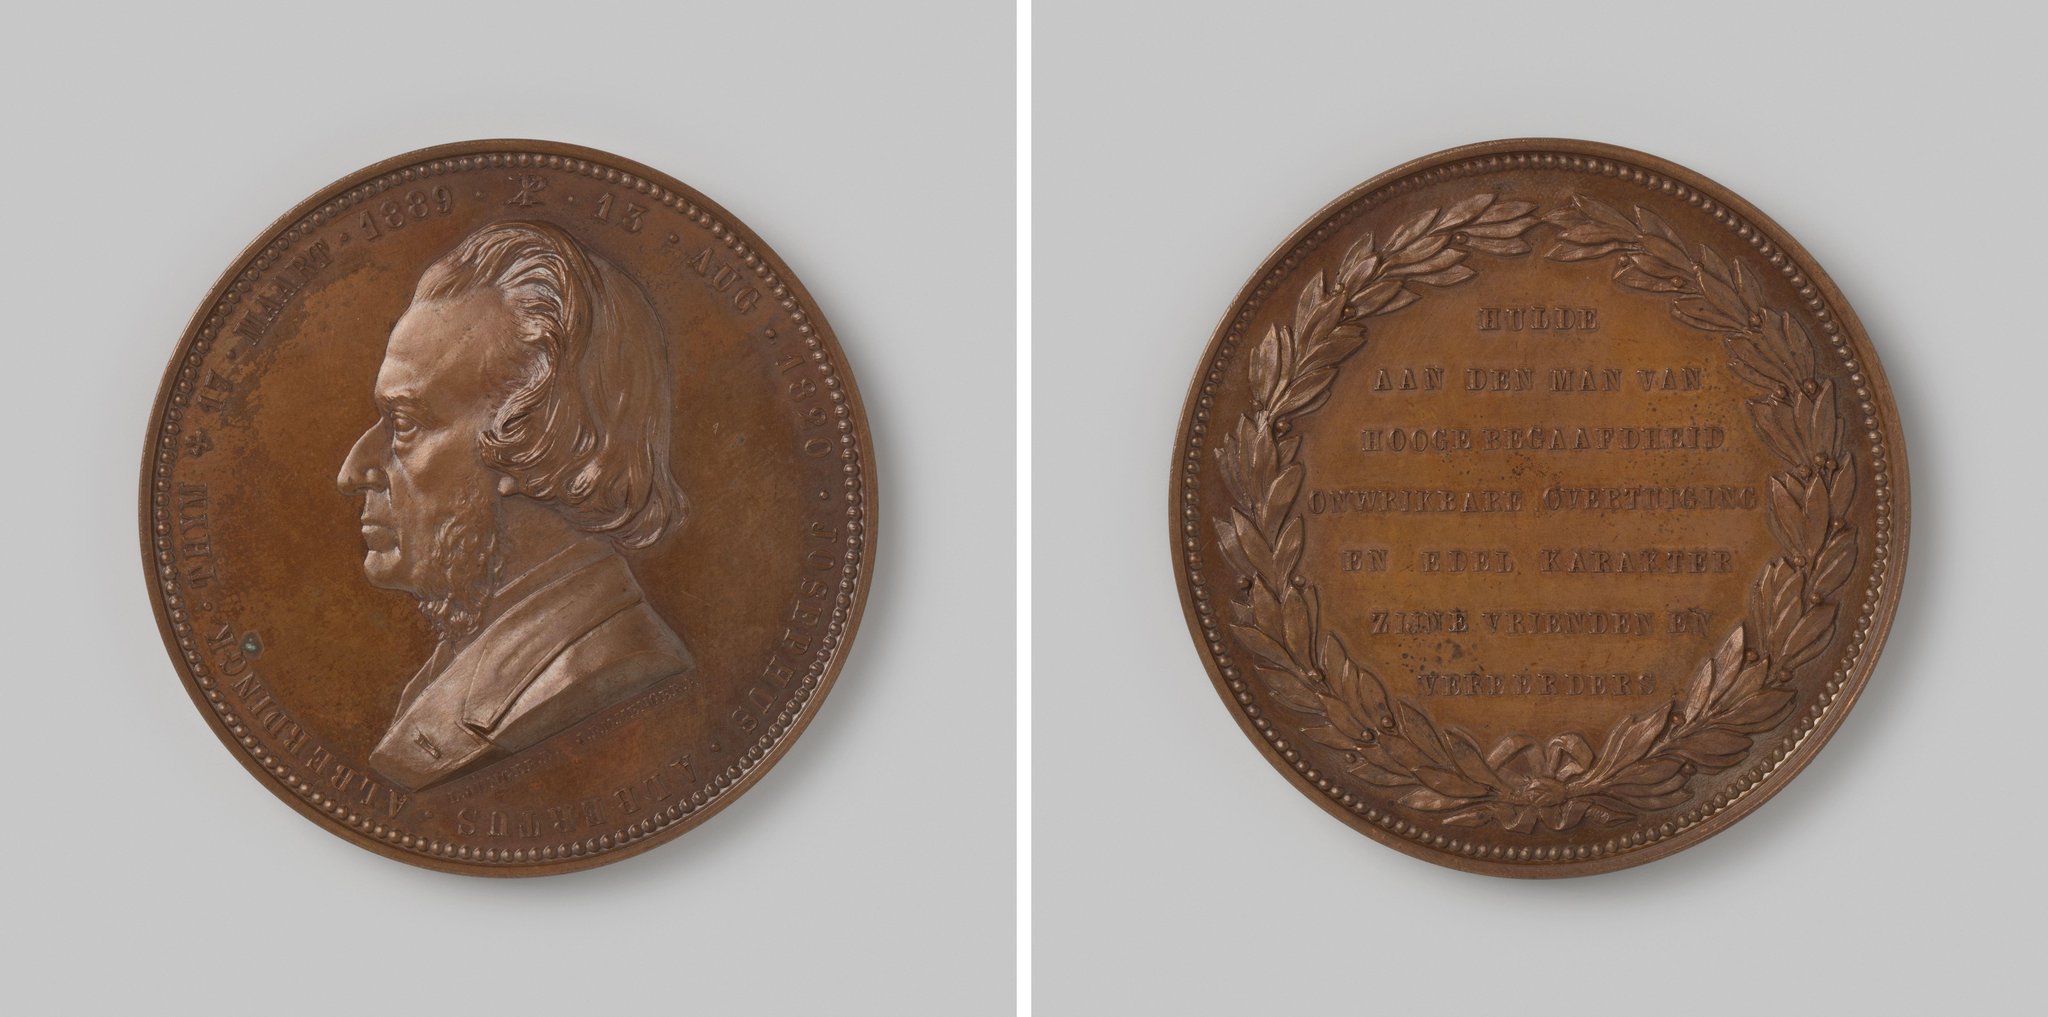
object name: history medal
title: Overlijden van Josephus Albertus Alberdingk Thym 1889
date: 1889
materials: bronze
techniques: striking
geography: amsterdam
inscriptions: factory mark: ‘mercuriusstaf’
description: Bronzen penning, op de voorzijde het borstbeeld van Alberdingk Thym naar links met omschrift, op de keerzijde zeven regels tekst tussen samengestrikte lauwertakken.